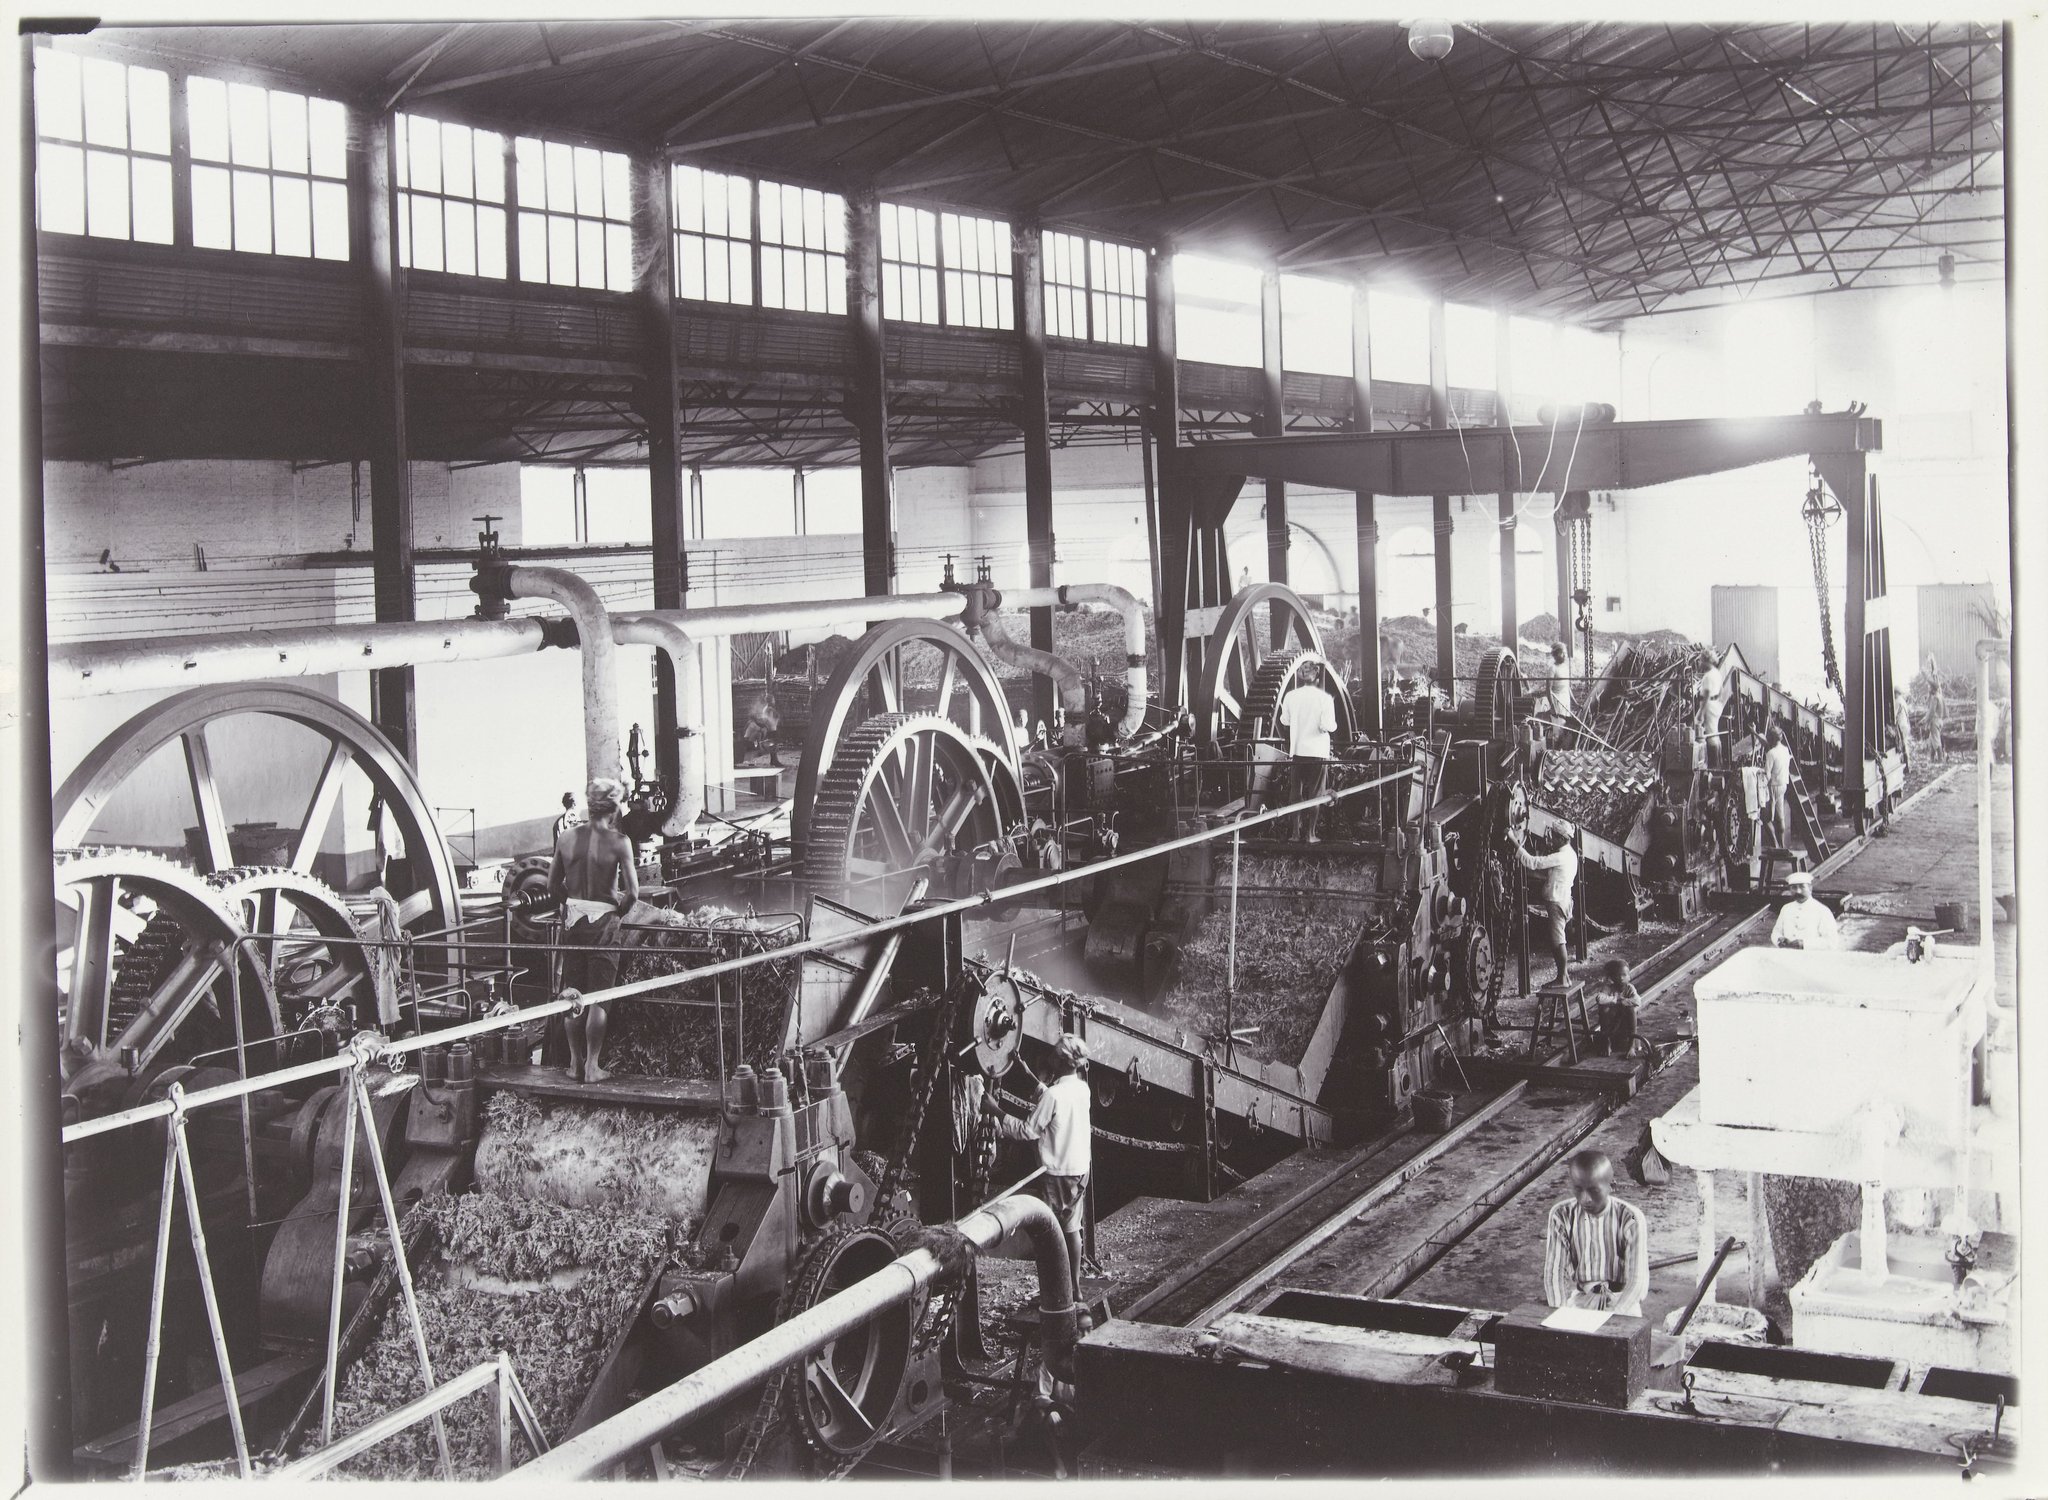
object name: photograph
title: Verwerken van suikerriet in de fabriek van de suikeronderneming Nieuw Tersana, Cheribon, voormalig Nederlands-Indië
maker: onnes kurkdjian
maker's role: fotograaf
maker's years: 1851-1903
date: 1890-1911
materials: paper, photographic support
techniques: gelatin silver print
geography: dutch east indies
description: Verwerken van suikerriet in de fabriek van de suikeronderneming Nieuw Tersana, Cheribon, voormalig Nederlands-Indië. Mannen bedien de machines die de suikerrietstengels vermalen.